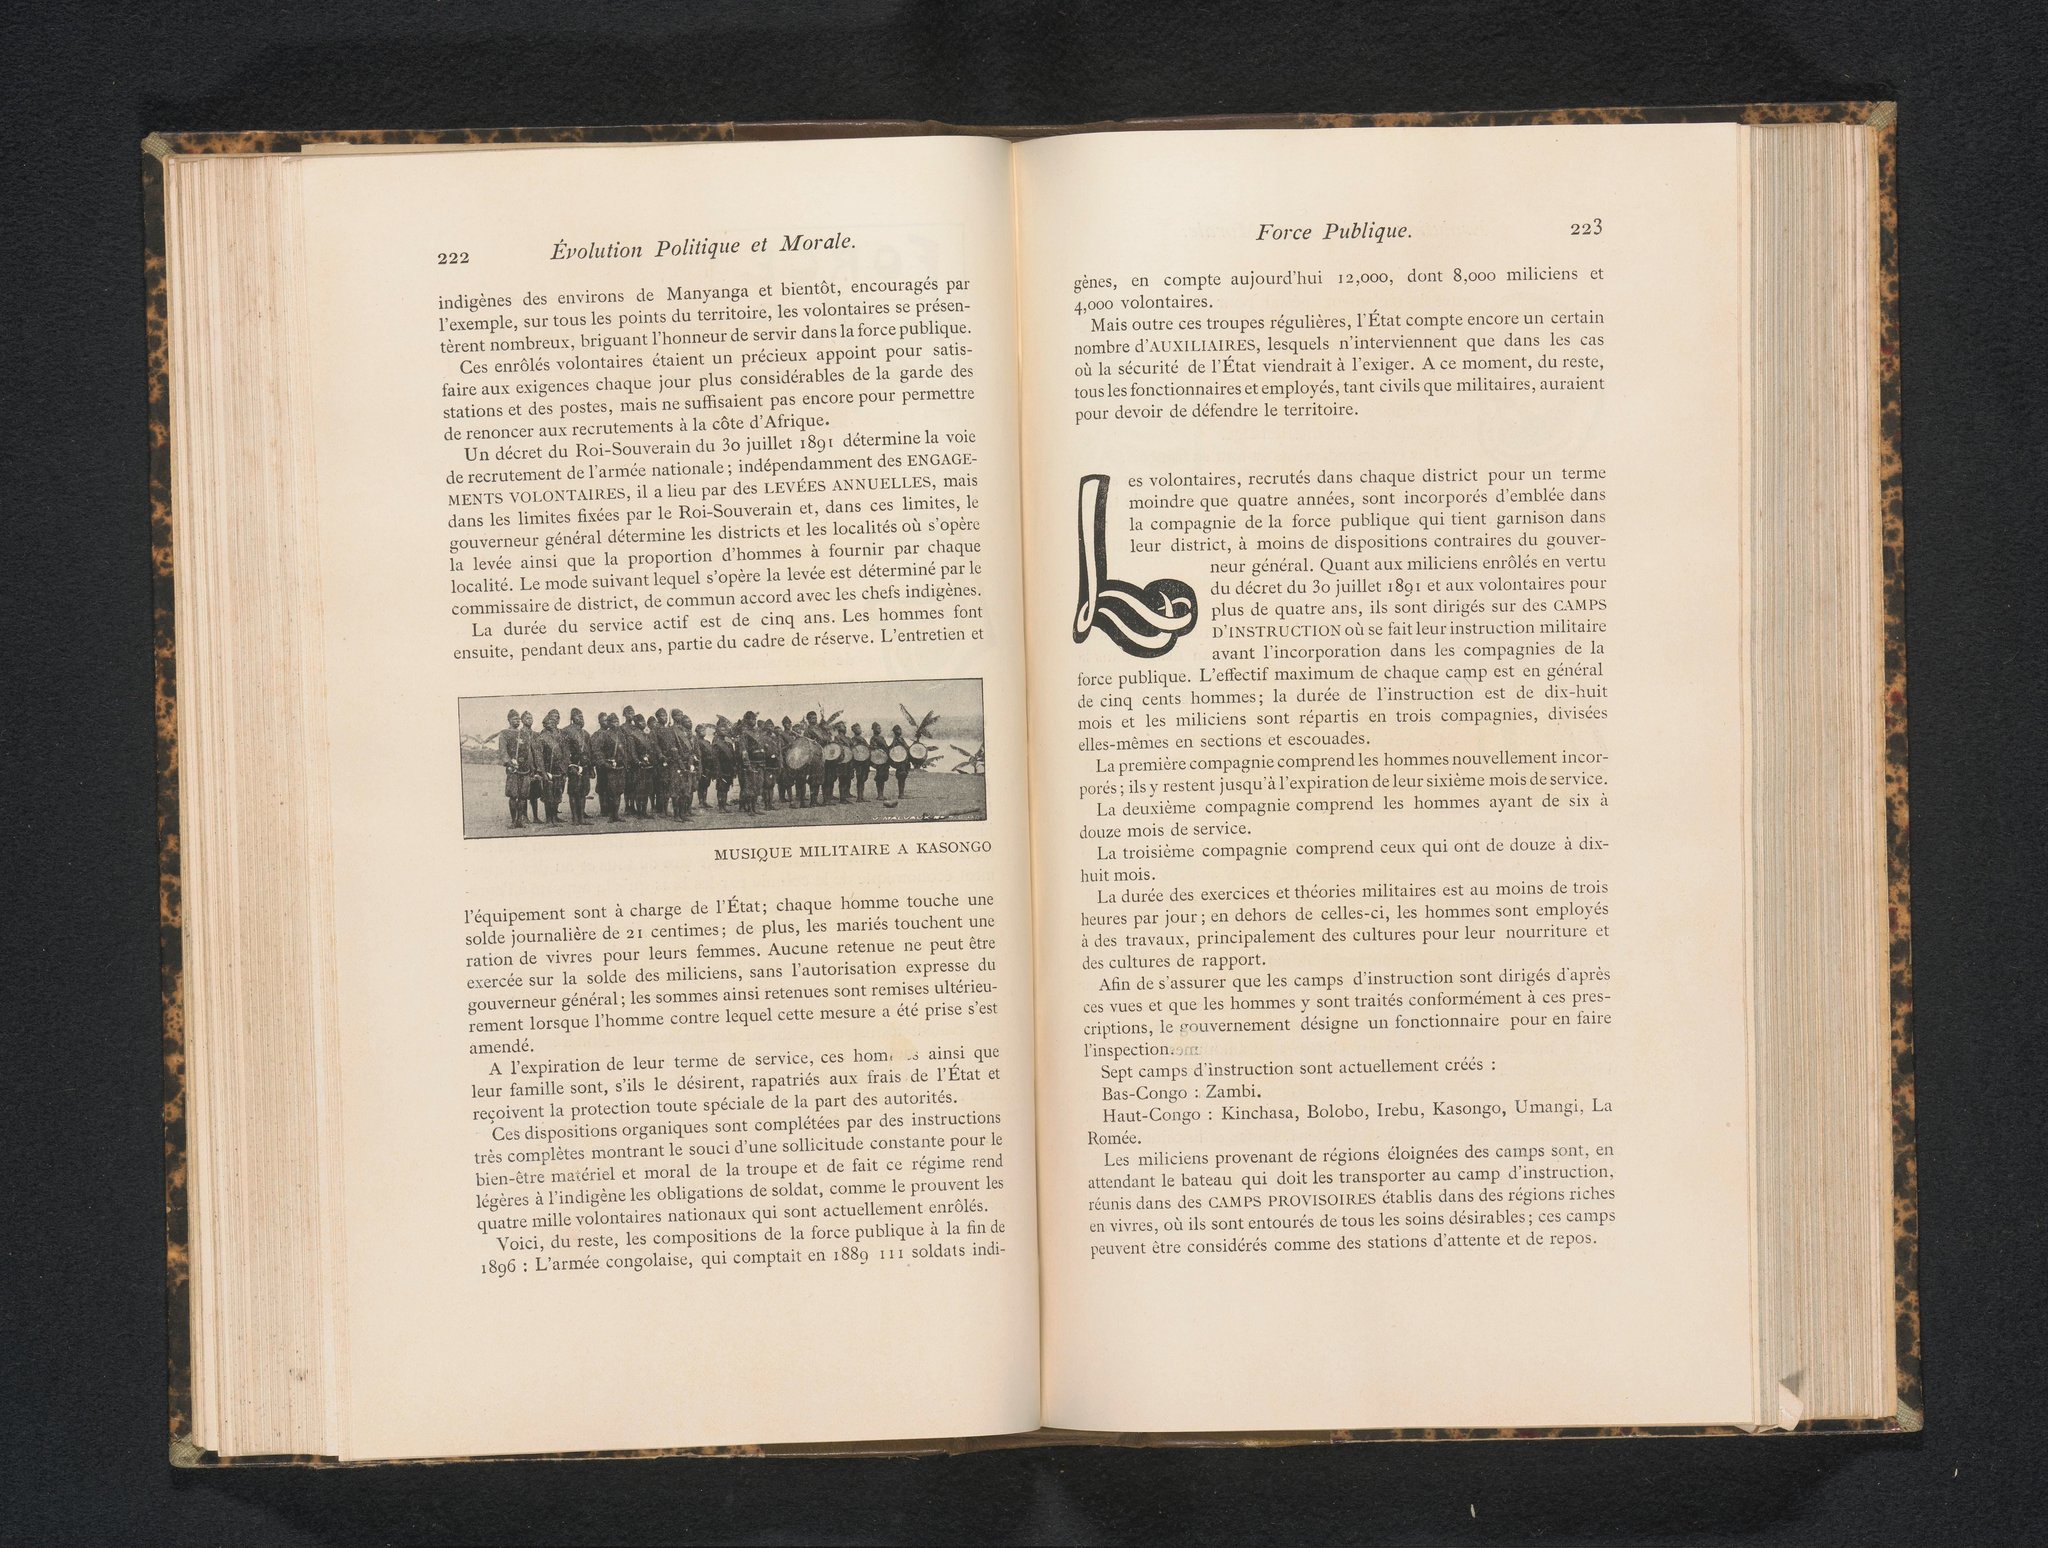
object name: photomechanical print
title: Militaire muziekkorps in Kasongo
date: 1887-1892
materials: paper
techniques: autotype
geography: congo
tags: military band